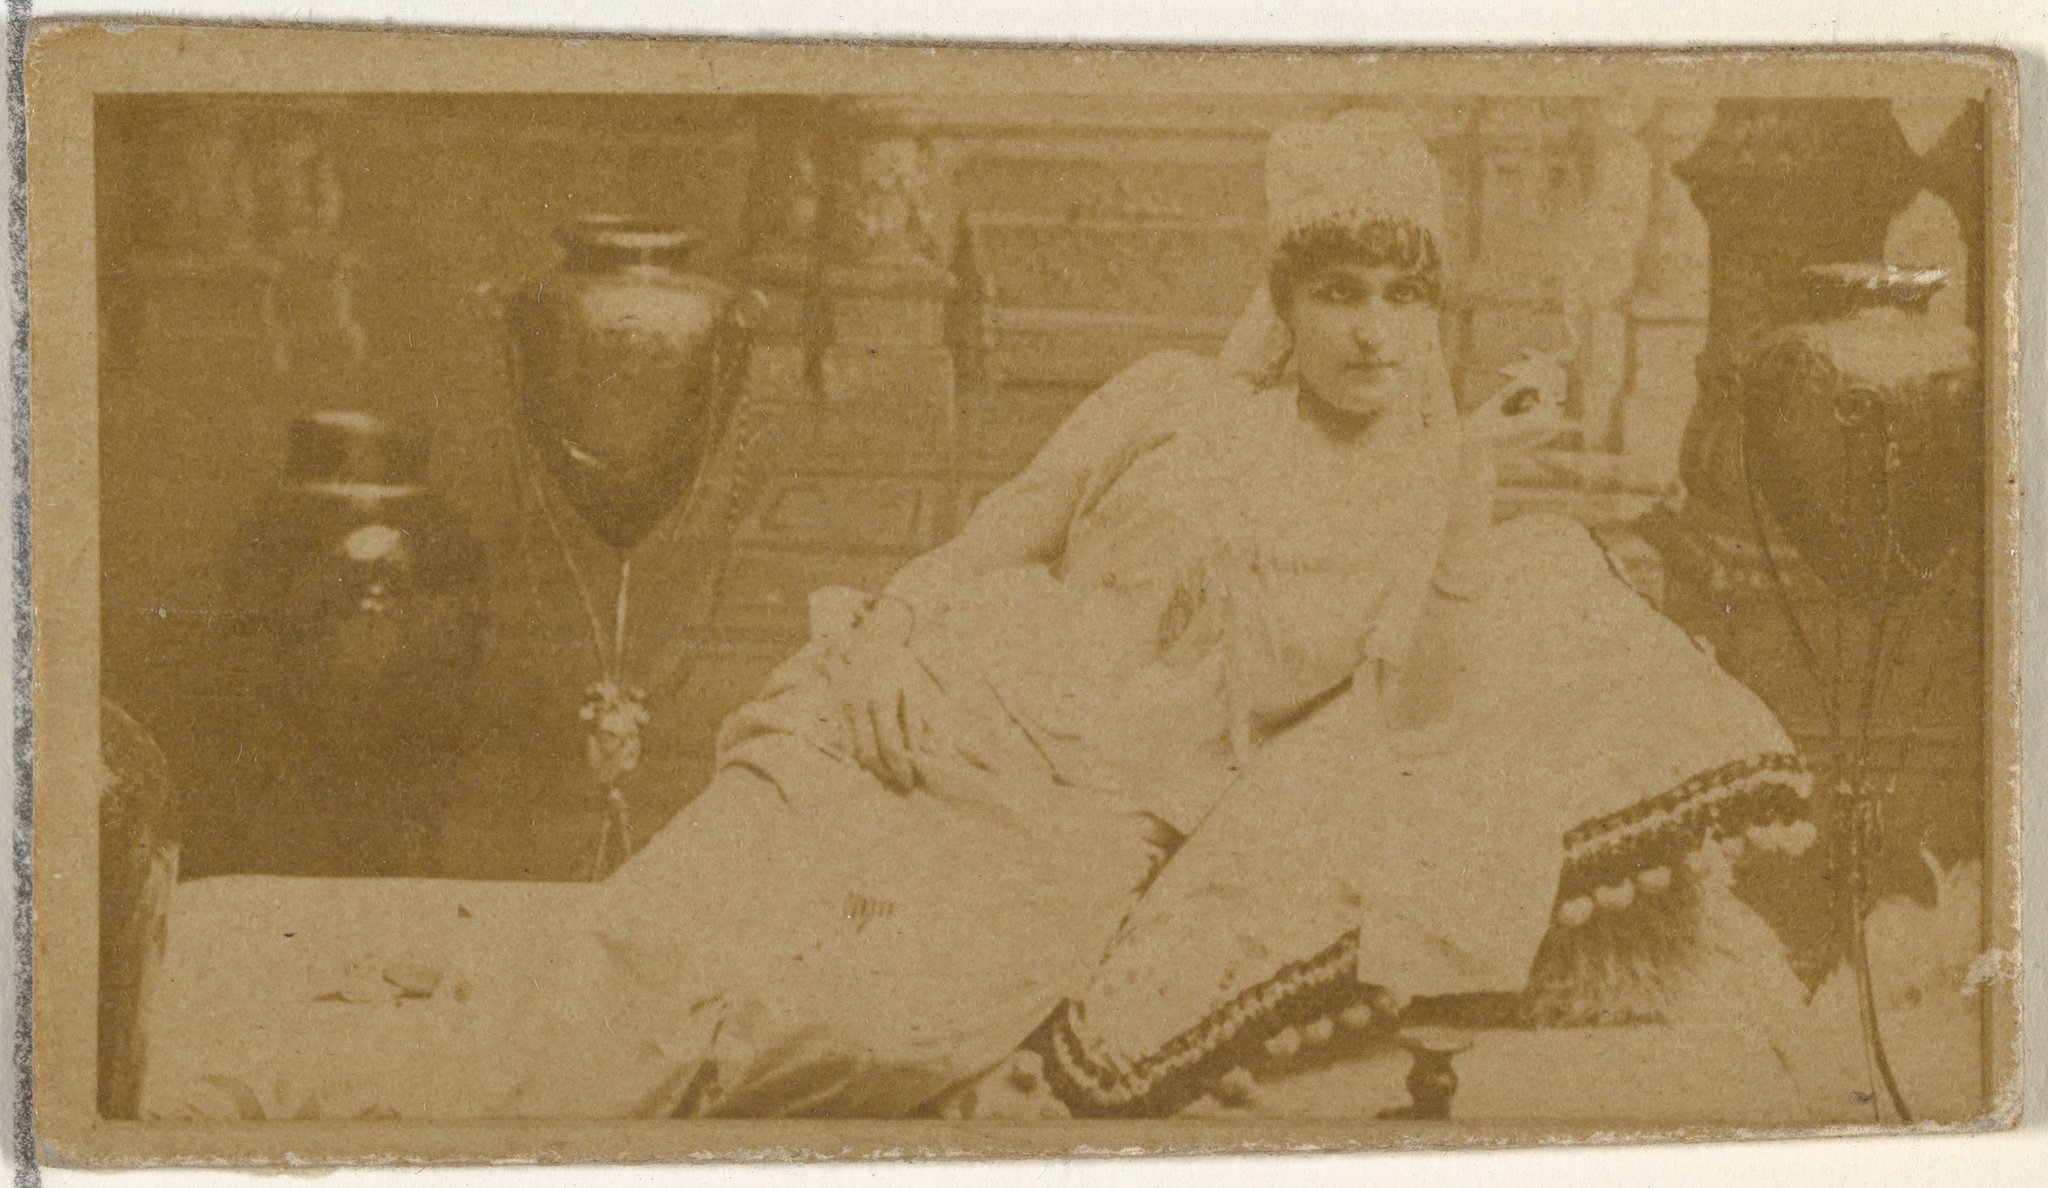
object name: photograph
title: [Reclining actress surrounded by vases], from the Actors and Actresses series (N145-8) issued by Duke Sons & Co. to promote Duke Cigarettes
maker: w. duke, sons & co.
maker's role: publisher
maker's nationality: american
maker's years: 1870-1920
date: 1891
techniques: albumen silver print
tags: portraits,women,actresses